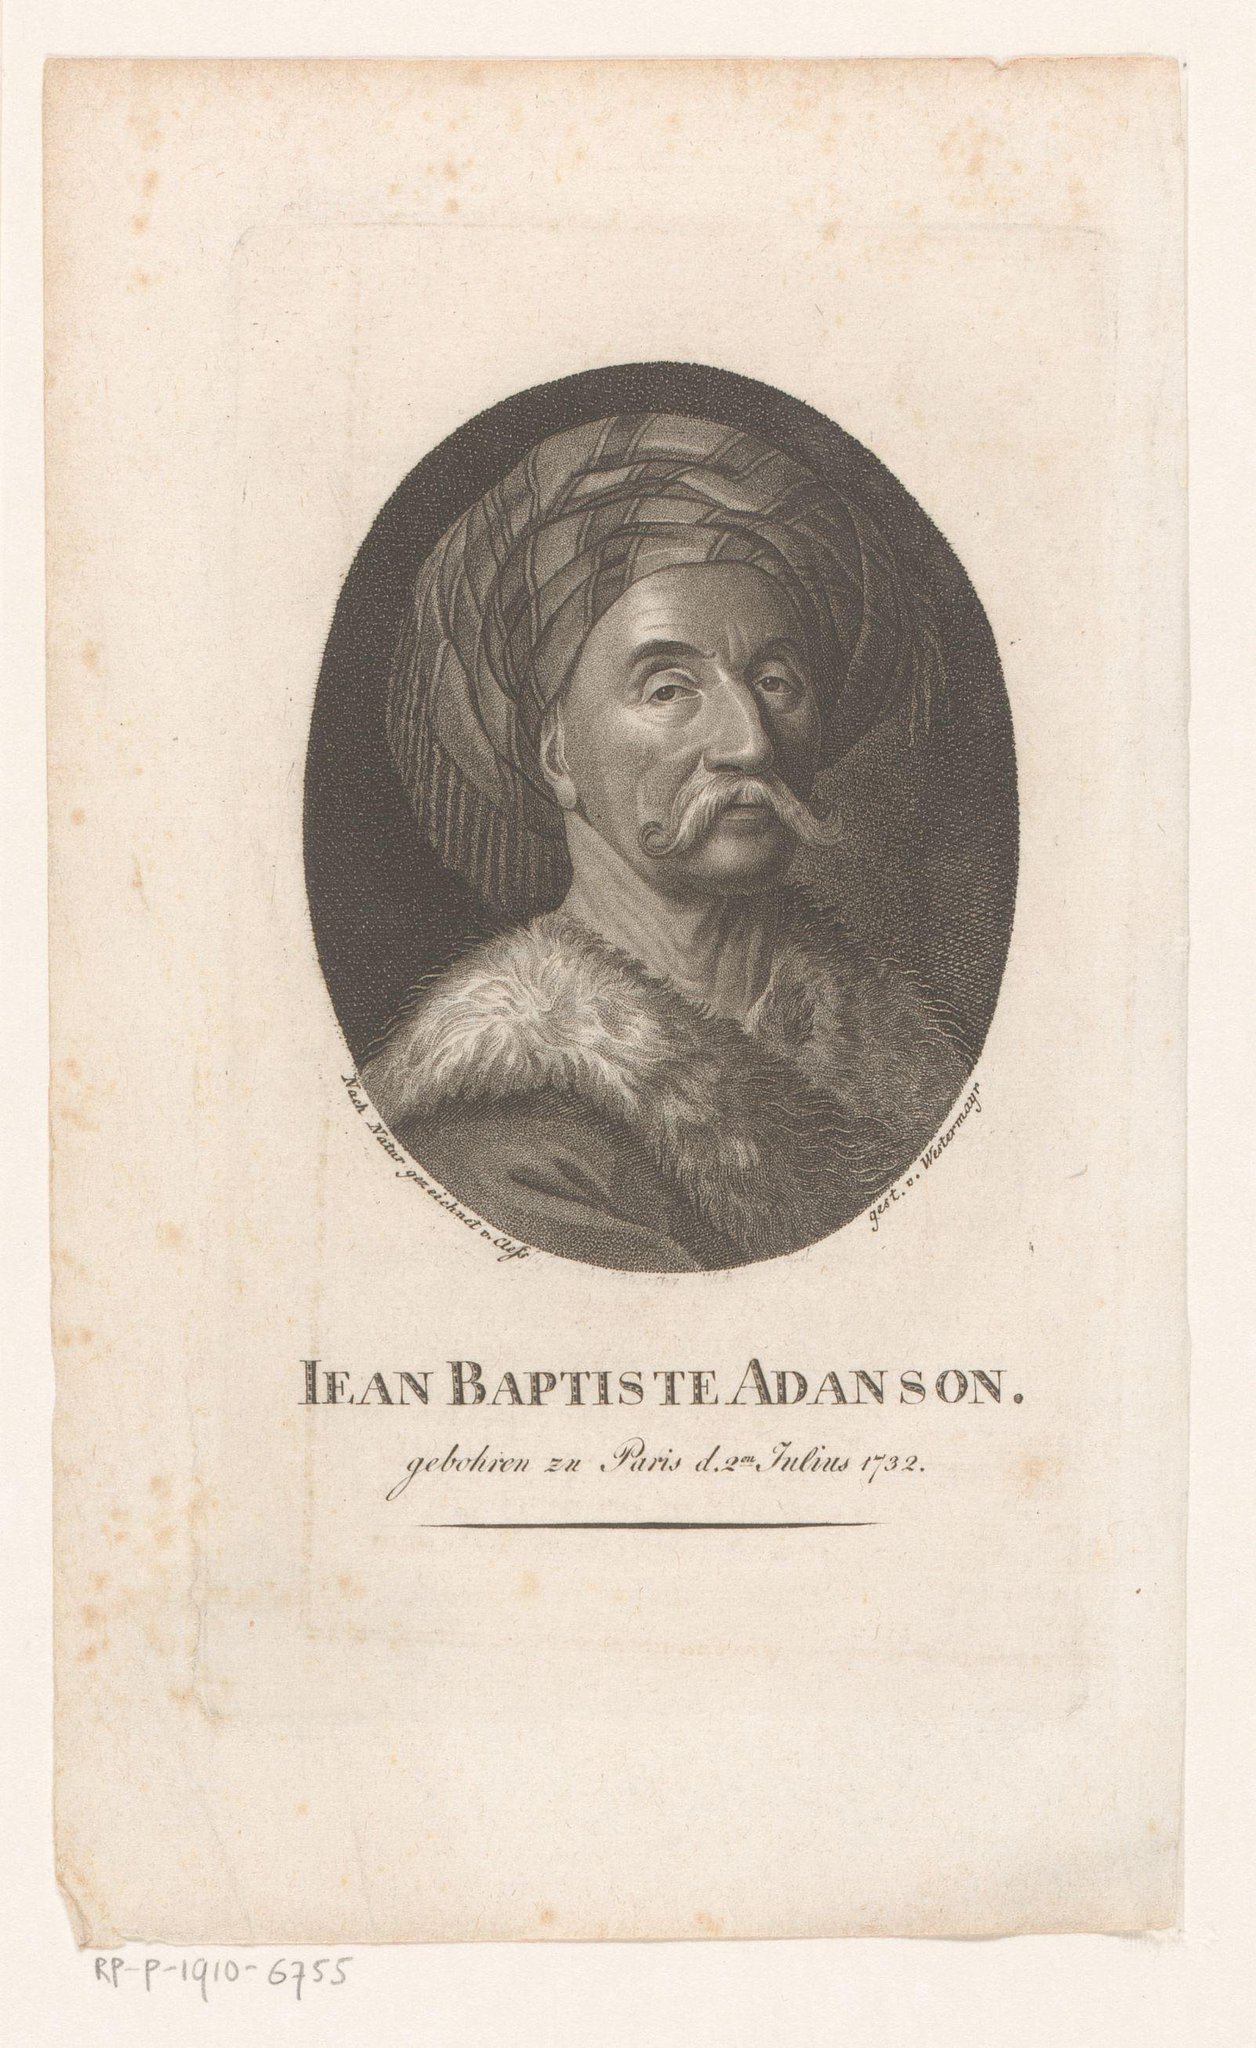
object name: print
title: Portret van Jean-Baptiste Adanson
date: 1784-1834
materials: paper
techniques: engraving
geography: germany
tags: paris, historical persons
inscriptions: collector's mark: Lugt 2228